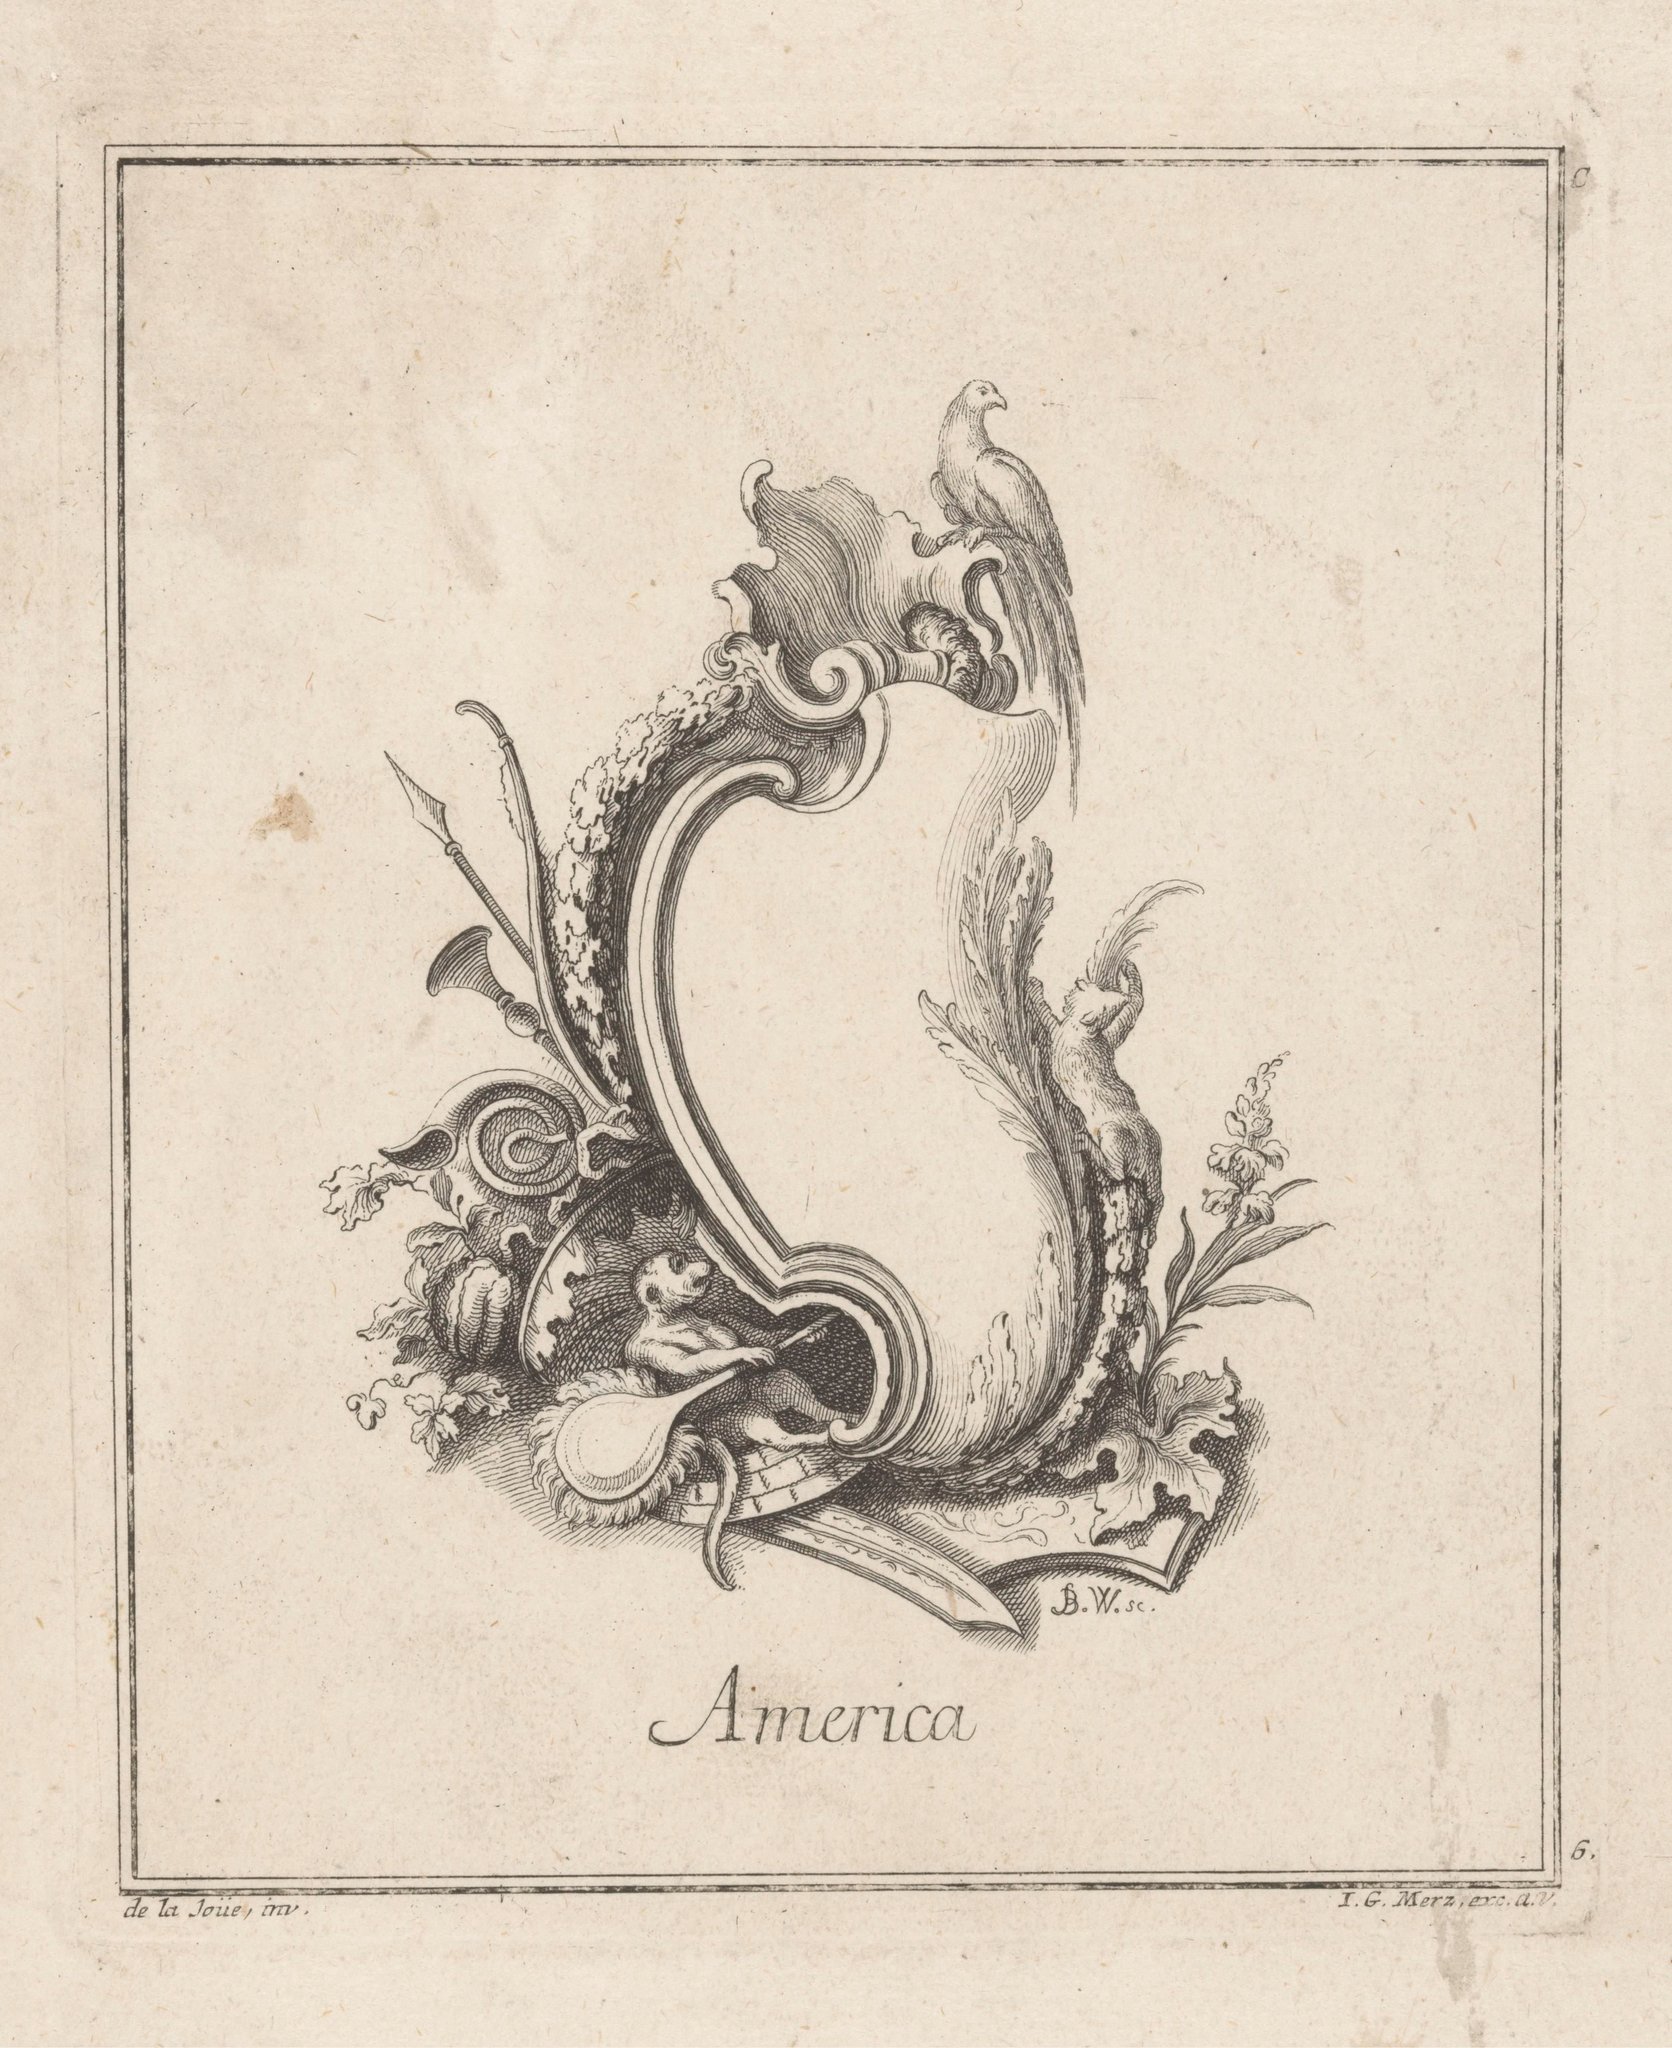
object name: ornament print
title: America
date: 1750-1762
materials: paper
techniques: etching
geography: augsburg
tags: america represented allegorically; 'america' (ripa), ornament ~ cartouche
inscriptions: collector's mark: Lugt 2760, collector's mark: Lugt 2228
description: Een cartouche omgeven door wapens en dieren zoals een aap met een waaier en een vogel.